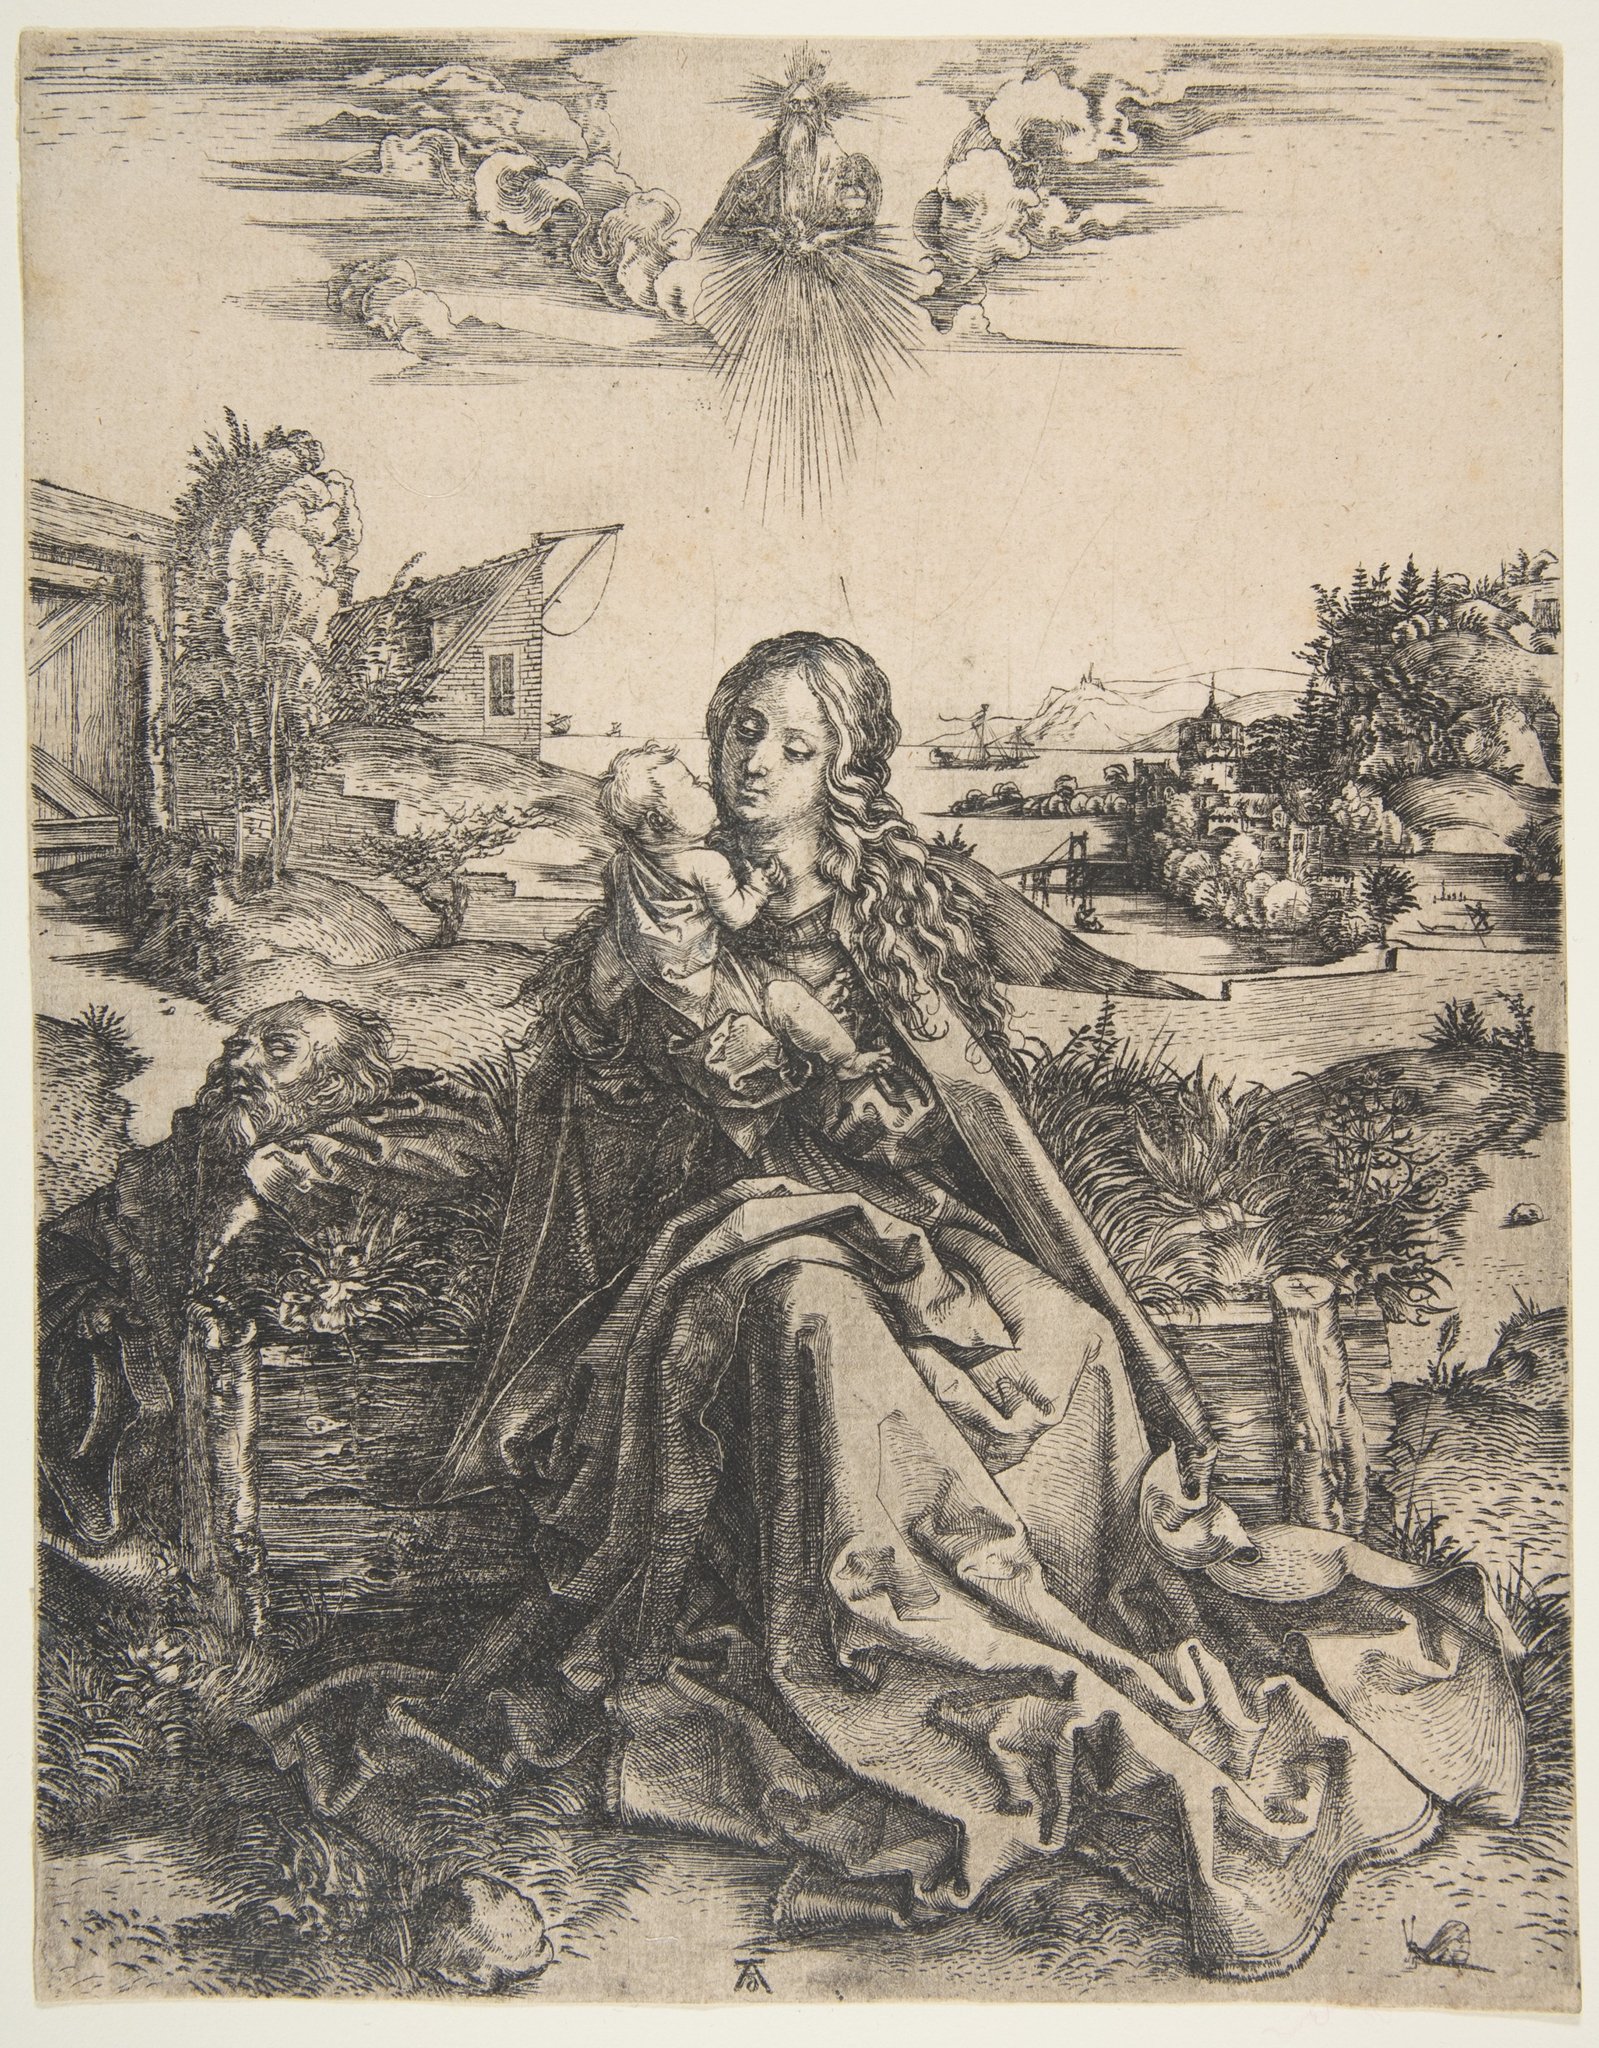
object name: print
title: Holy Family with a Dragonfly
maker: albrecht dürer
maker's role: artist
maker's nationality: german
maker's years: 1471-1528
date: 1495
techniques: engraving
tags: men,dragonflies,holy family,madonna and child